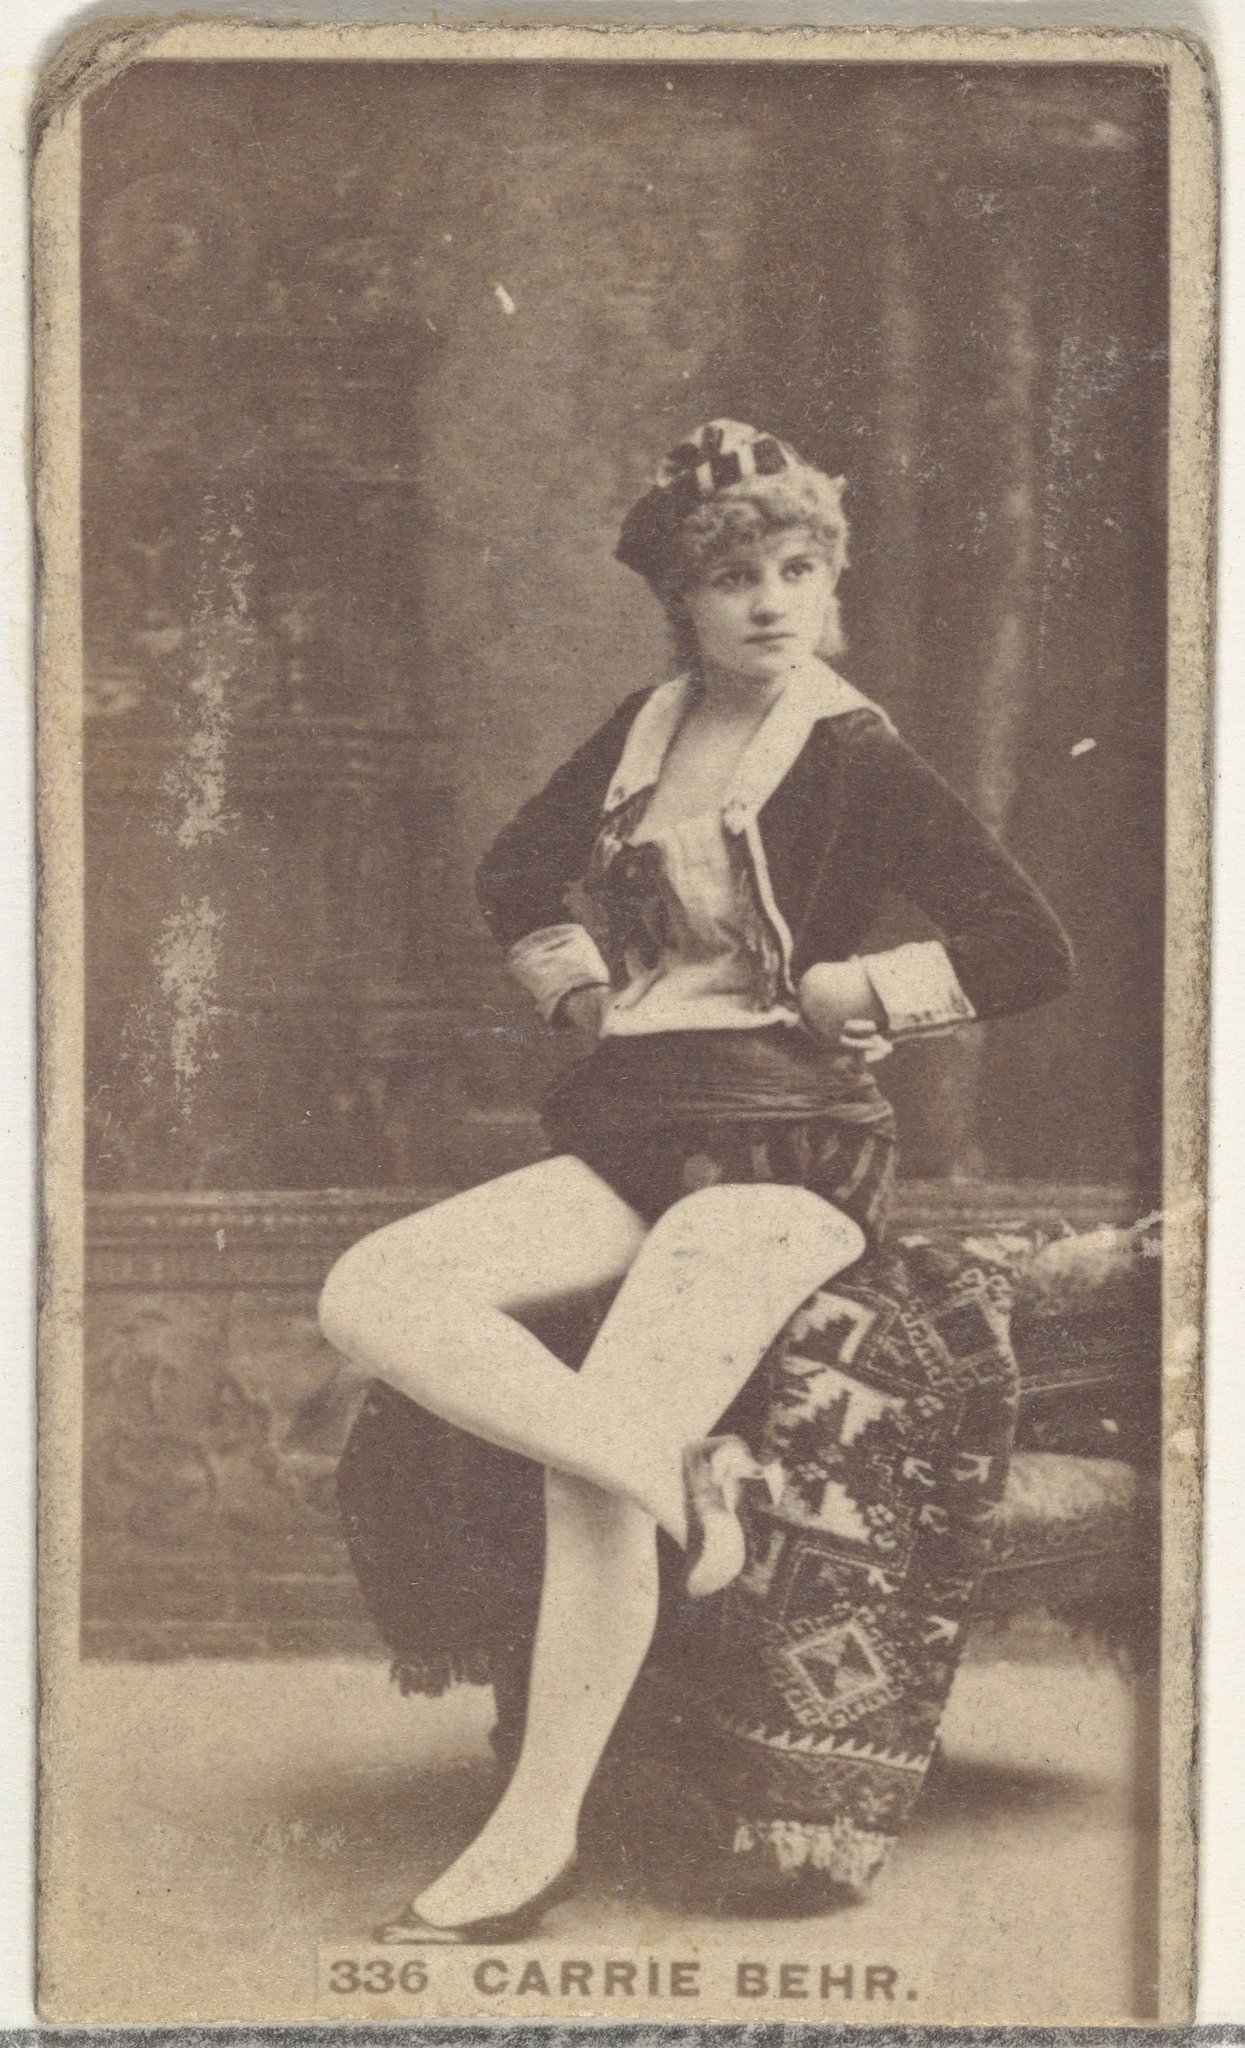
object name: photograph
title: Card Number 336, Carrie Behr, from the Actors and Actresses series (N145-7) issued by Duke Sons & Co. to promote Duke Cigarettes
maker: w. duke, sons & co.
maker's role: publisher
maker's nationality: american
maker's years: 1870-1920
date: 1880-1889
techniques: albumen silver print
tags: portraits,women,actresses